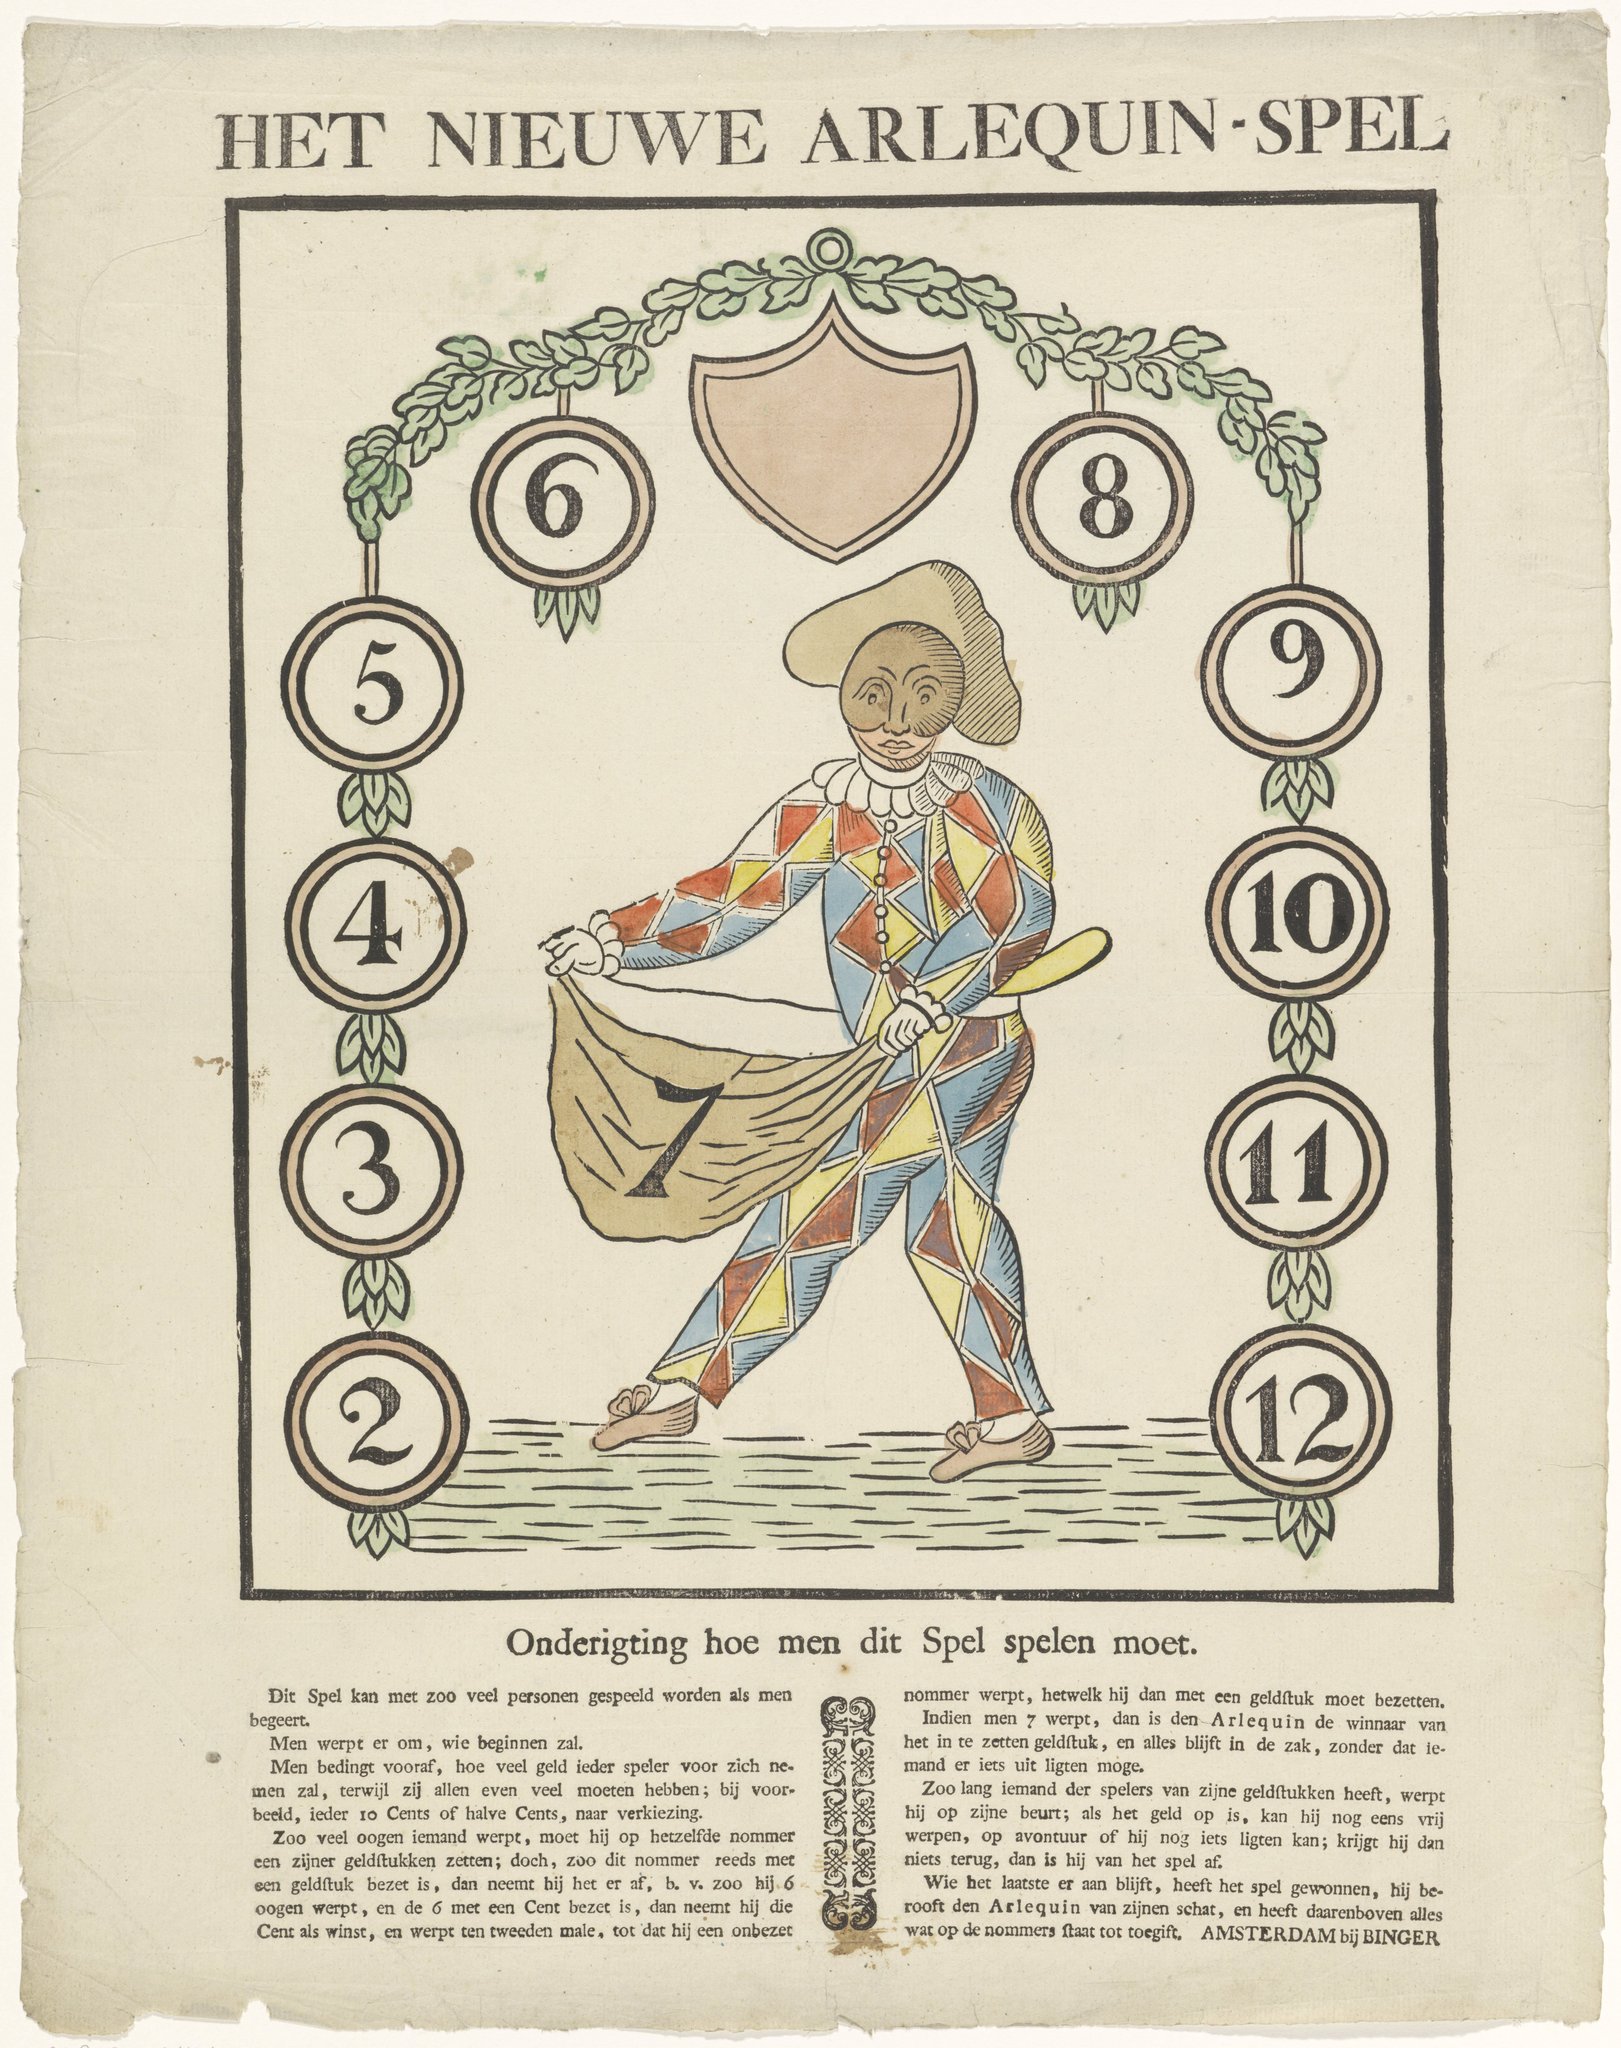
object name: print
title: Het nieuwe Arlequin-spel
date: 1816-1897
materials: paper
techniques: colour, letterpress printing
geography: amsterdam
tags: board-games of chance, types in 'commedia dell'arte': harlequin, board-games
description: Bordspel met in het midden van het speelveld een harlekijn die in zijn geopende handen een zak houdt met daarop het cijfer 7. Rondom hem een guirlande waaraan medaillons hangen met de cijfers 2 tot en met 12. Bovenaan in het midden een schild. Onder de voorstelling de spelregels in het Nederlands in twee kolommen.